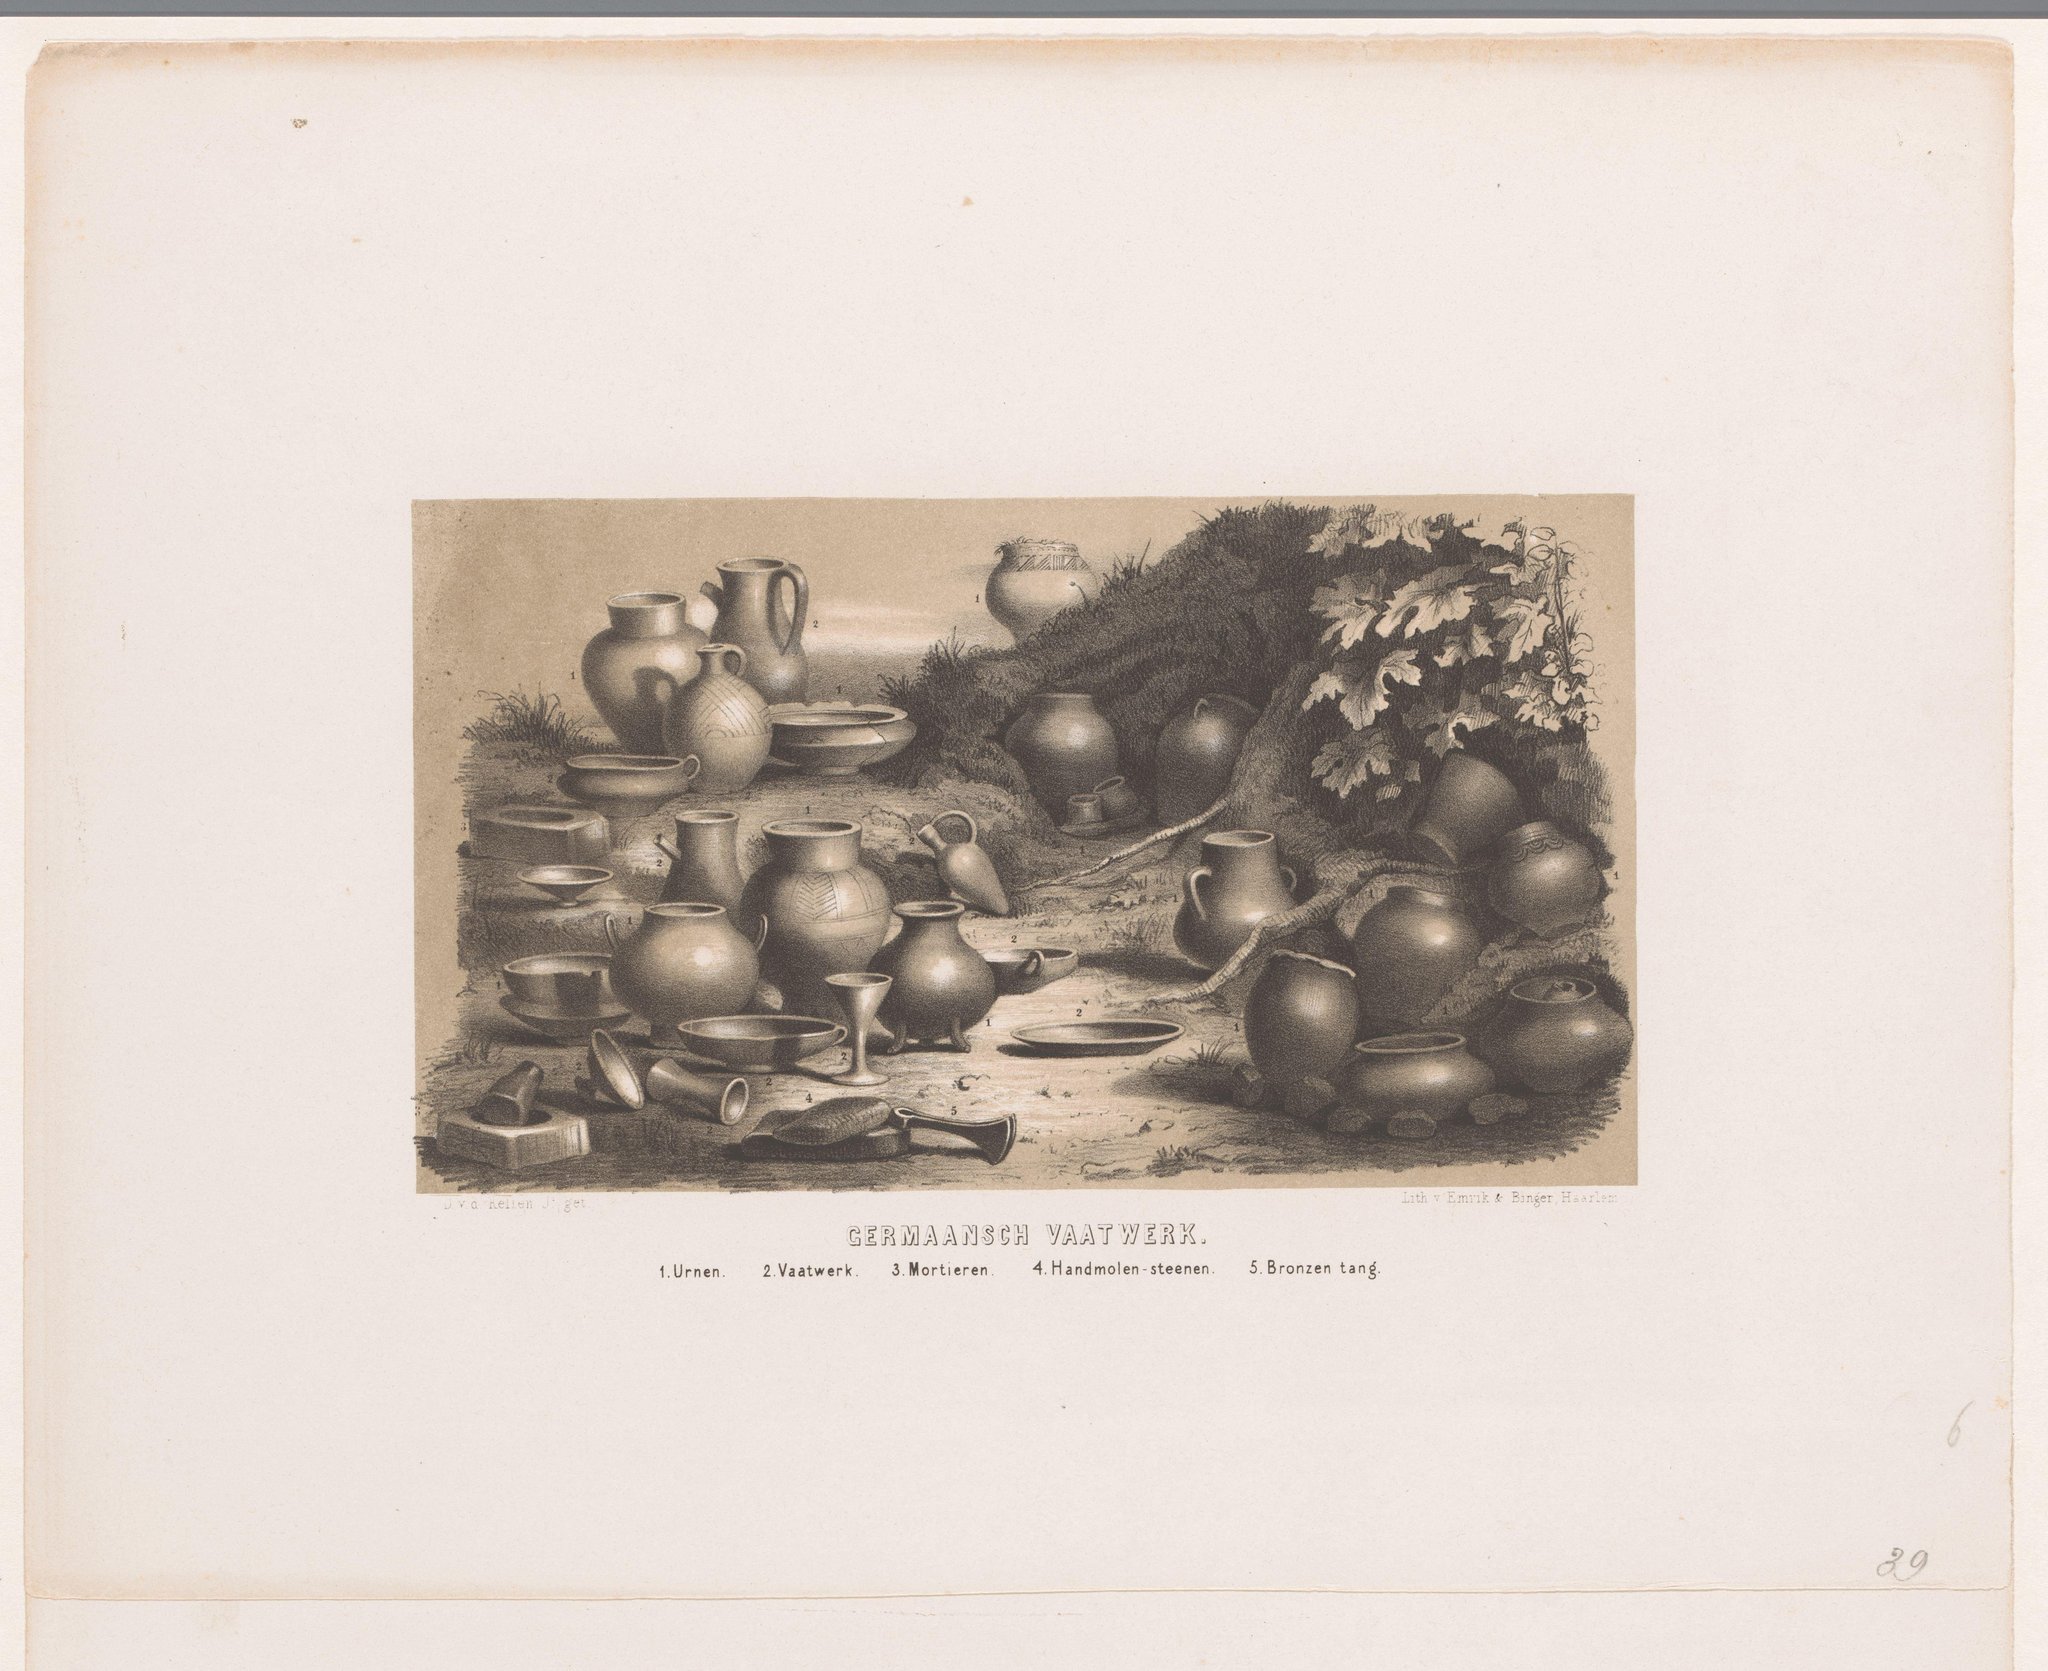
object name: historical object representation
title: Germaans vaatwerk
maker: david van der kellen (1827-1895)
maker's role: draughtsman, print maker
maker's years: 1827-1895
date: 1857-1864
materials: paper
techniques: tone lithography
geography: haarlem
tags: netherlands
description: Illustratie voor: W.J. Hofdijk, Ons voorgeslacht in zijn dagelyksch leven geschilderd, Kruseman, Haarlem 1859-1864.